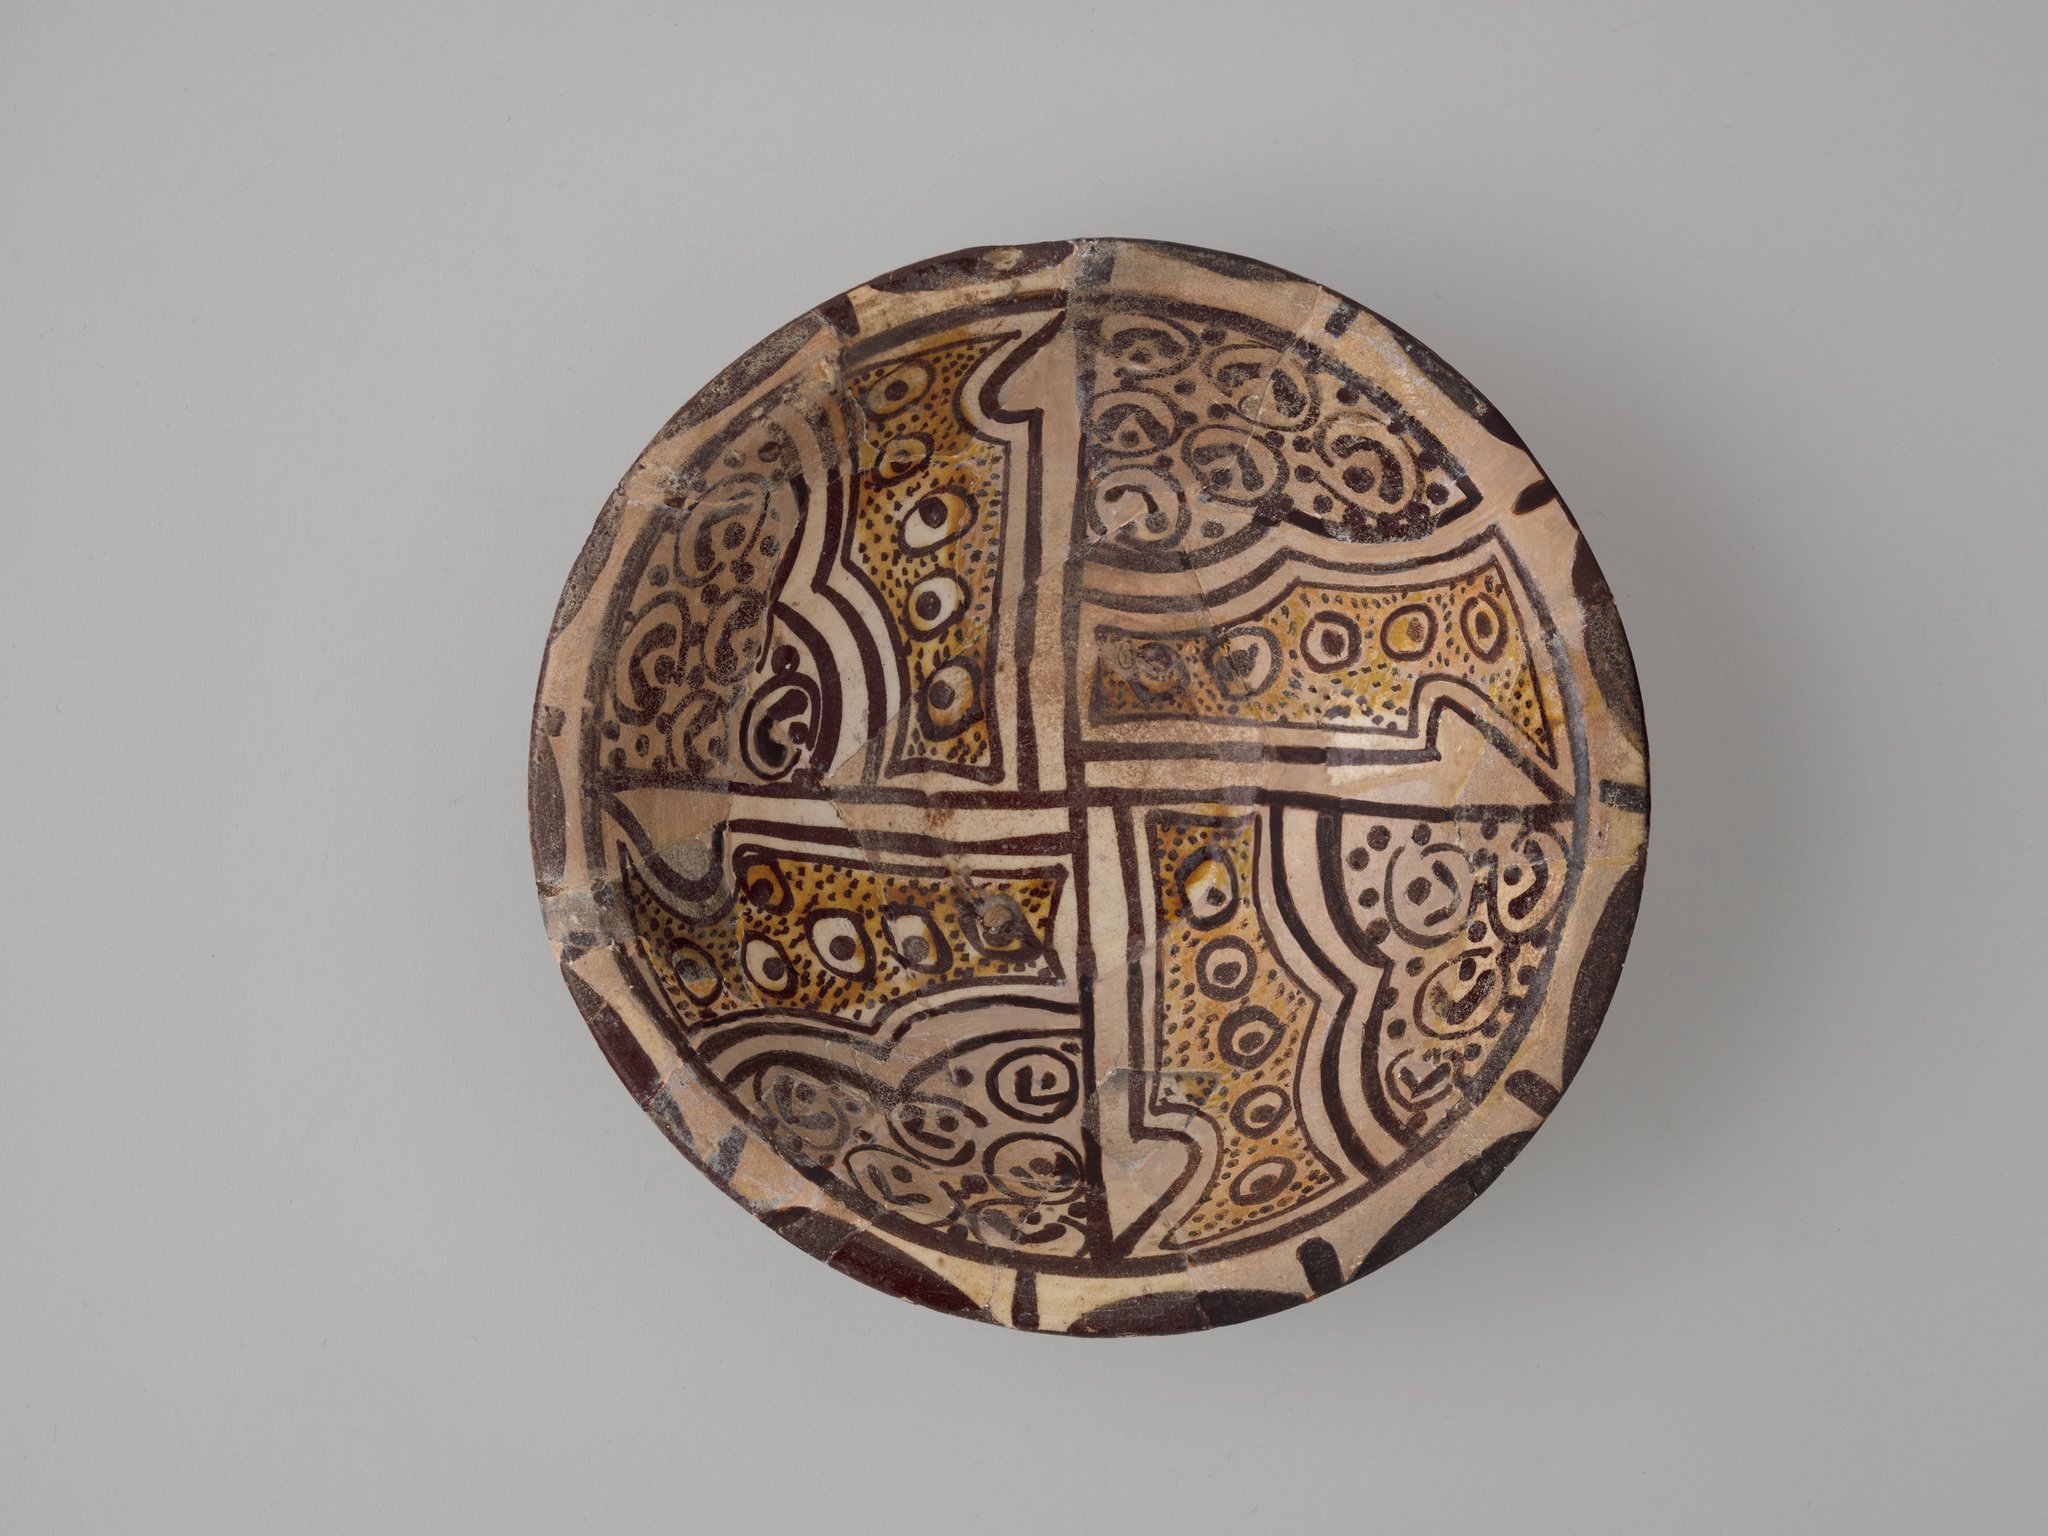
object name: bowl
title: Imitation Bichrome Luster Bowl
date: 801-900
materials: earthenware, glaze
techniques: polychrome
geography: iran